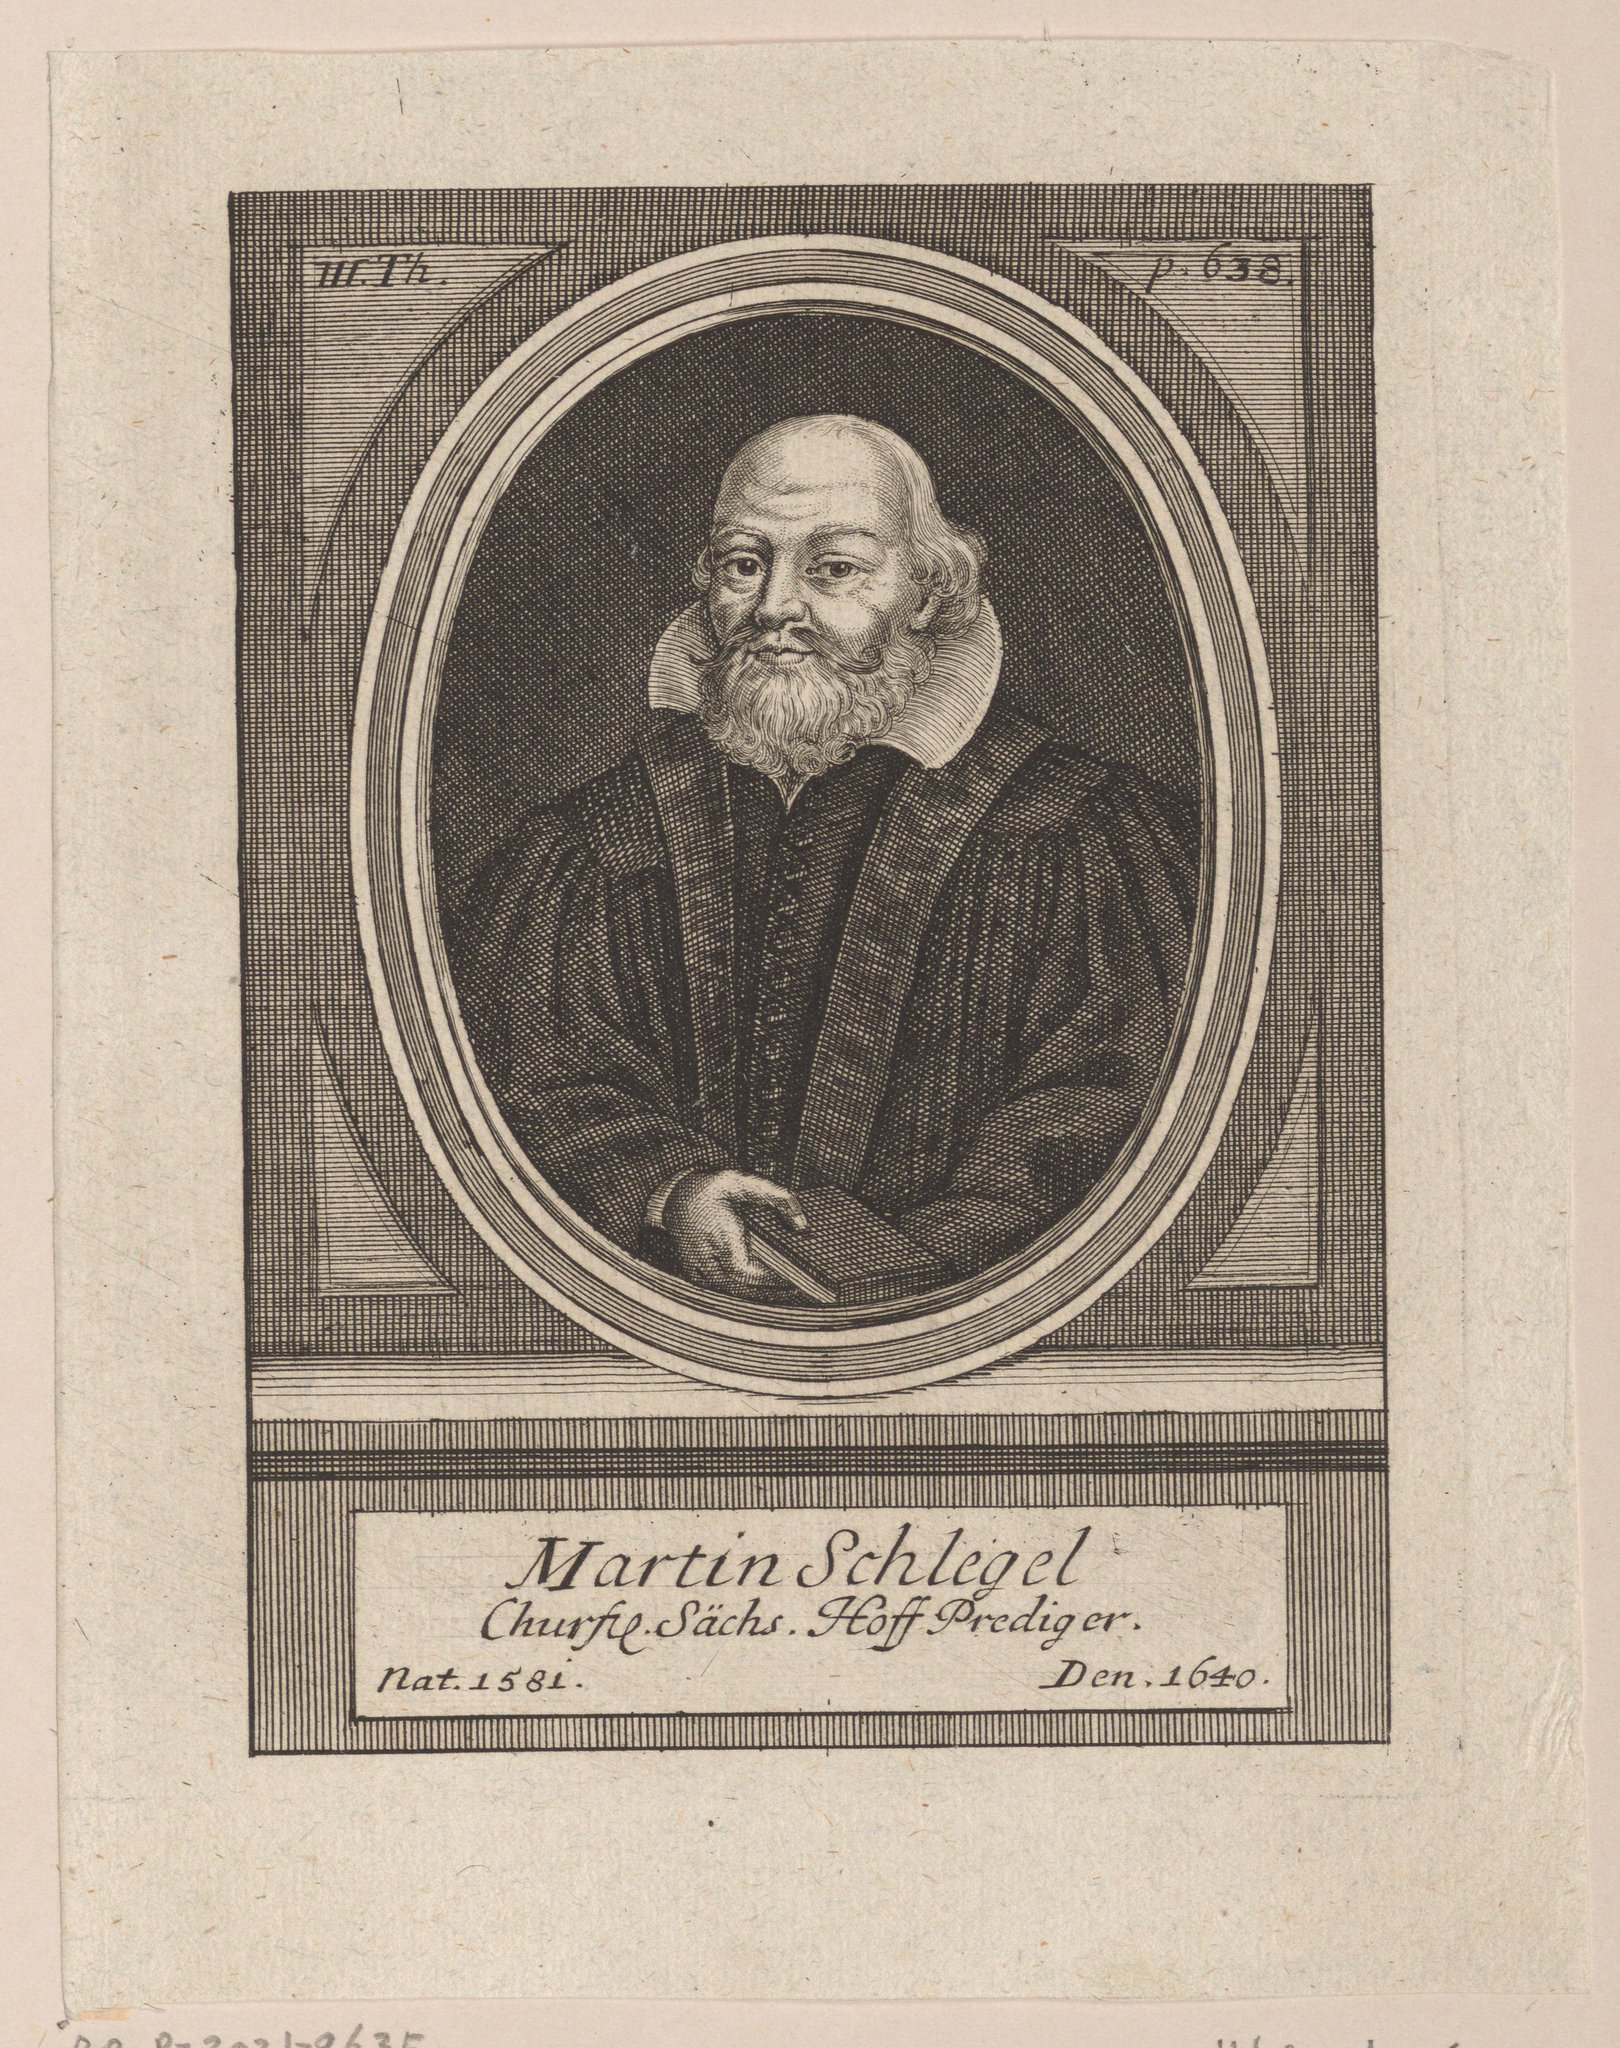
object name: print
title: Portret van Martin Schlegel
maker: Anonymous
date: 1730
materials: paper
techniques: engraving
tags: theologian, historical persons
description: Prent waarschijnlijk uit: Gleich, Johann Andreas. Annales Ecclesiastici, Oder Gründliche Nachrichten der Reformations-Historie (...). Dresden en Leipzig: Raphael Christian Saueressig, 1730, dl. 3, p. 638.